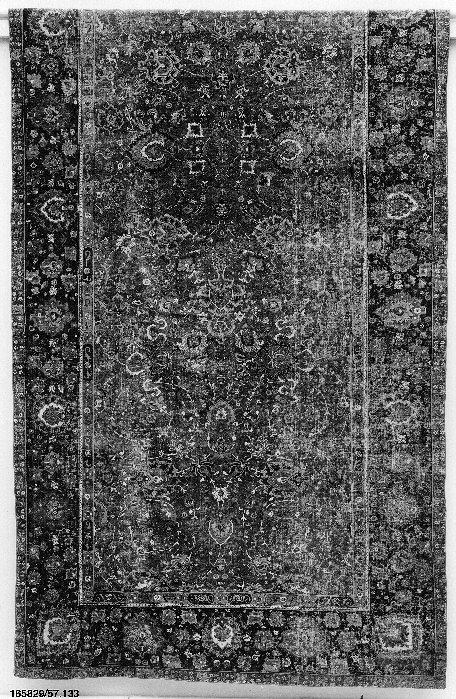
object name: carpet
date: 1601-1633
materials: wool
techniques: asymmetrically knotted pile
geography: iran